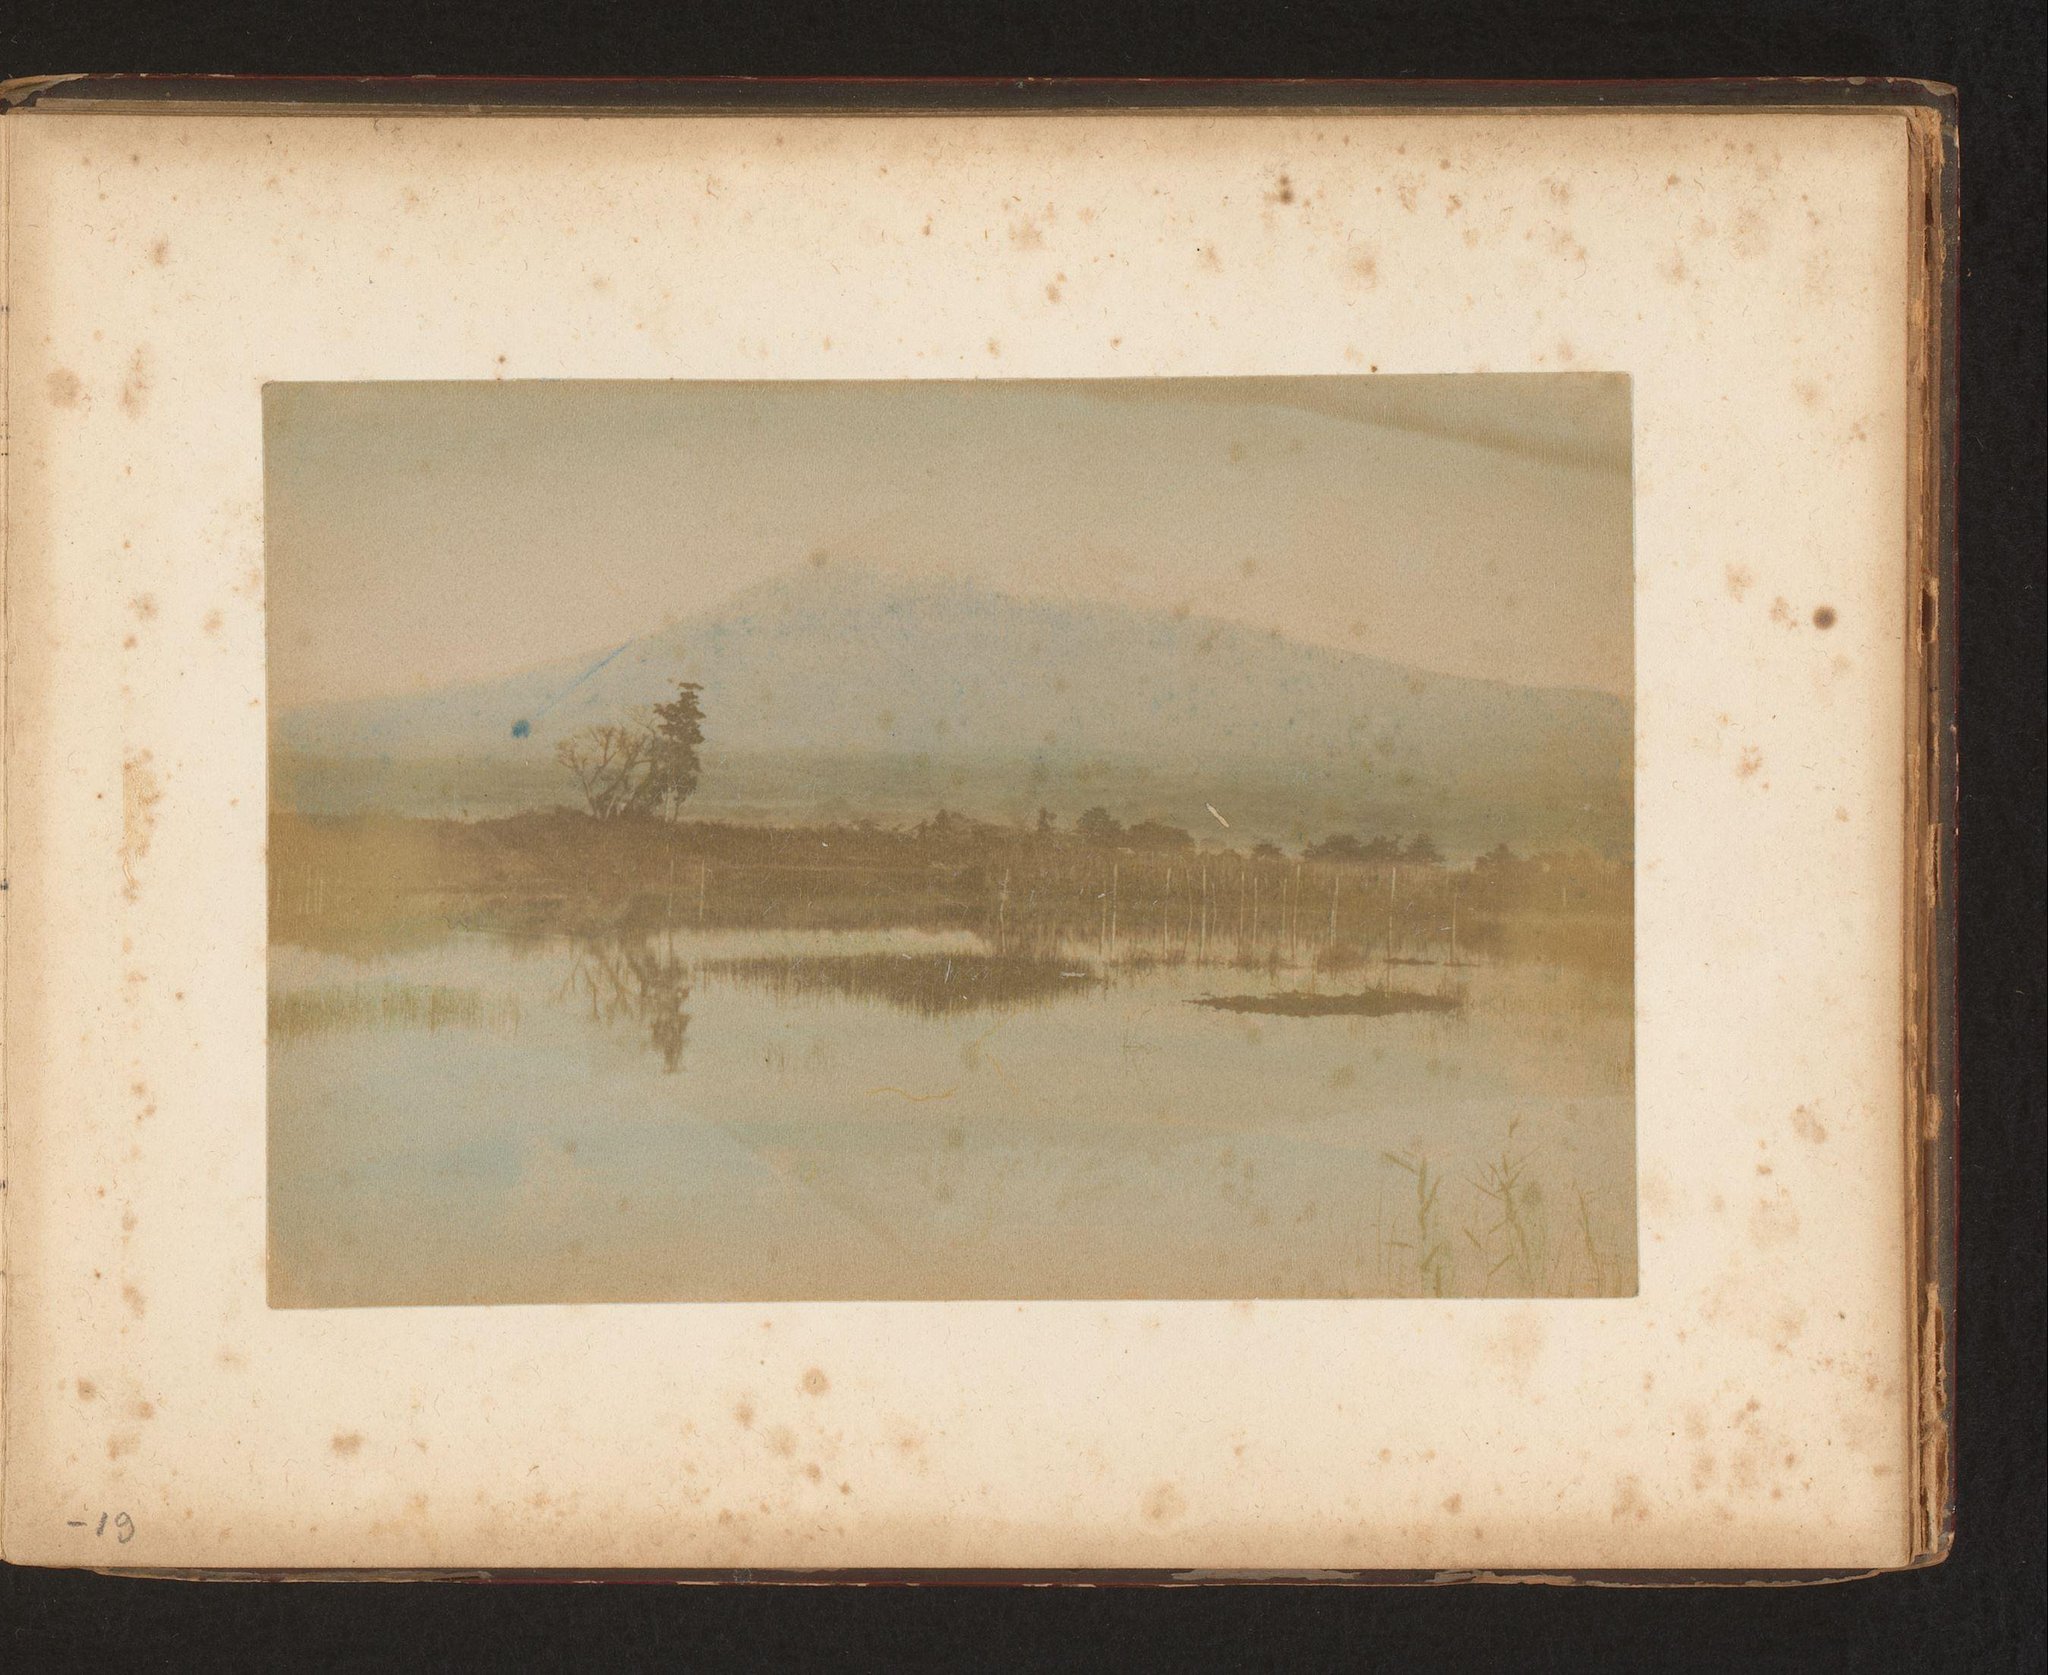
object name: album leaf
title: Gebergte in Japan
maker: Anonymous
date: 1851-1900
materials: paper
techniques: albumen print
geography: japan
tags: mountains, japan